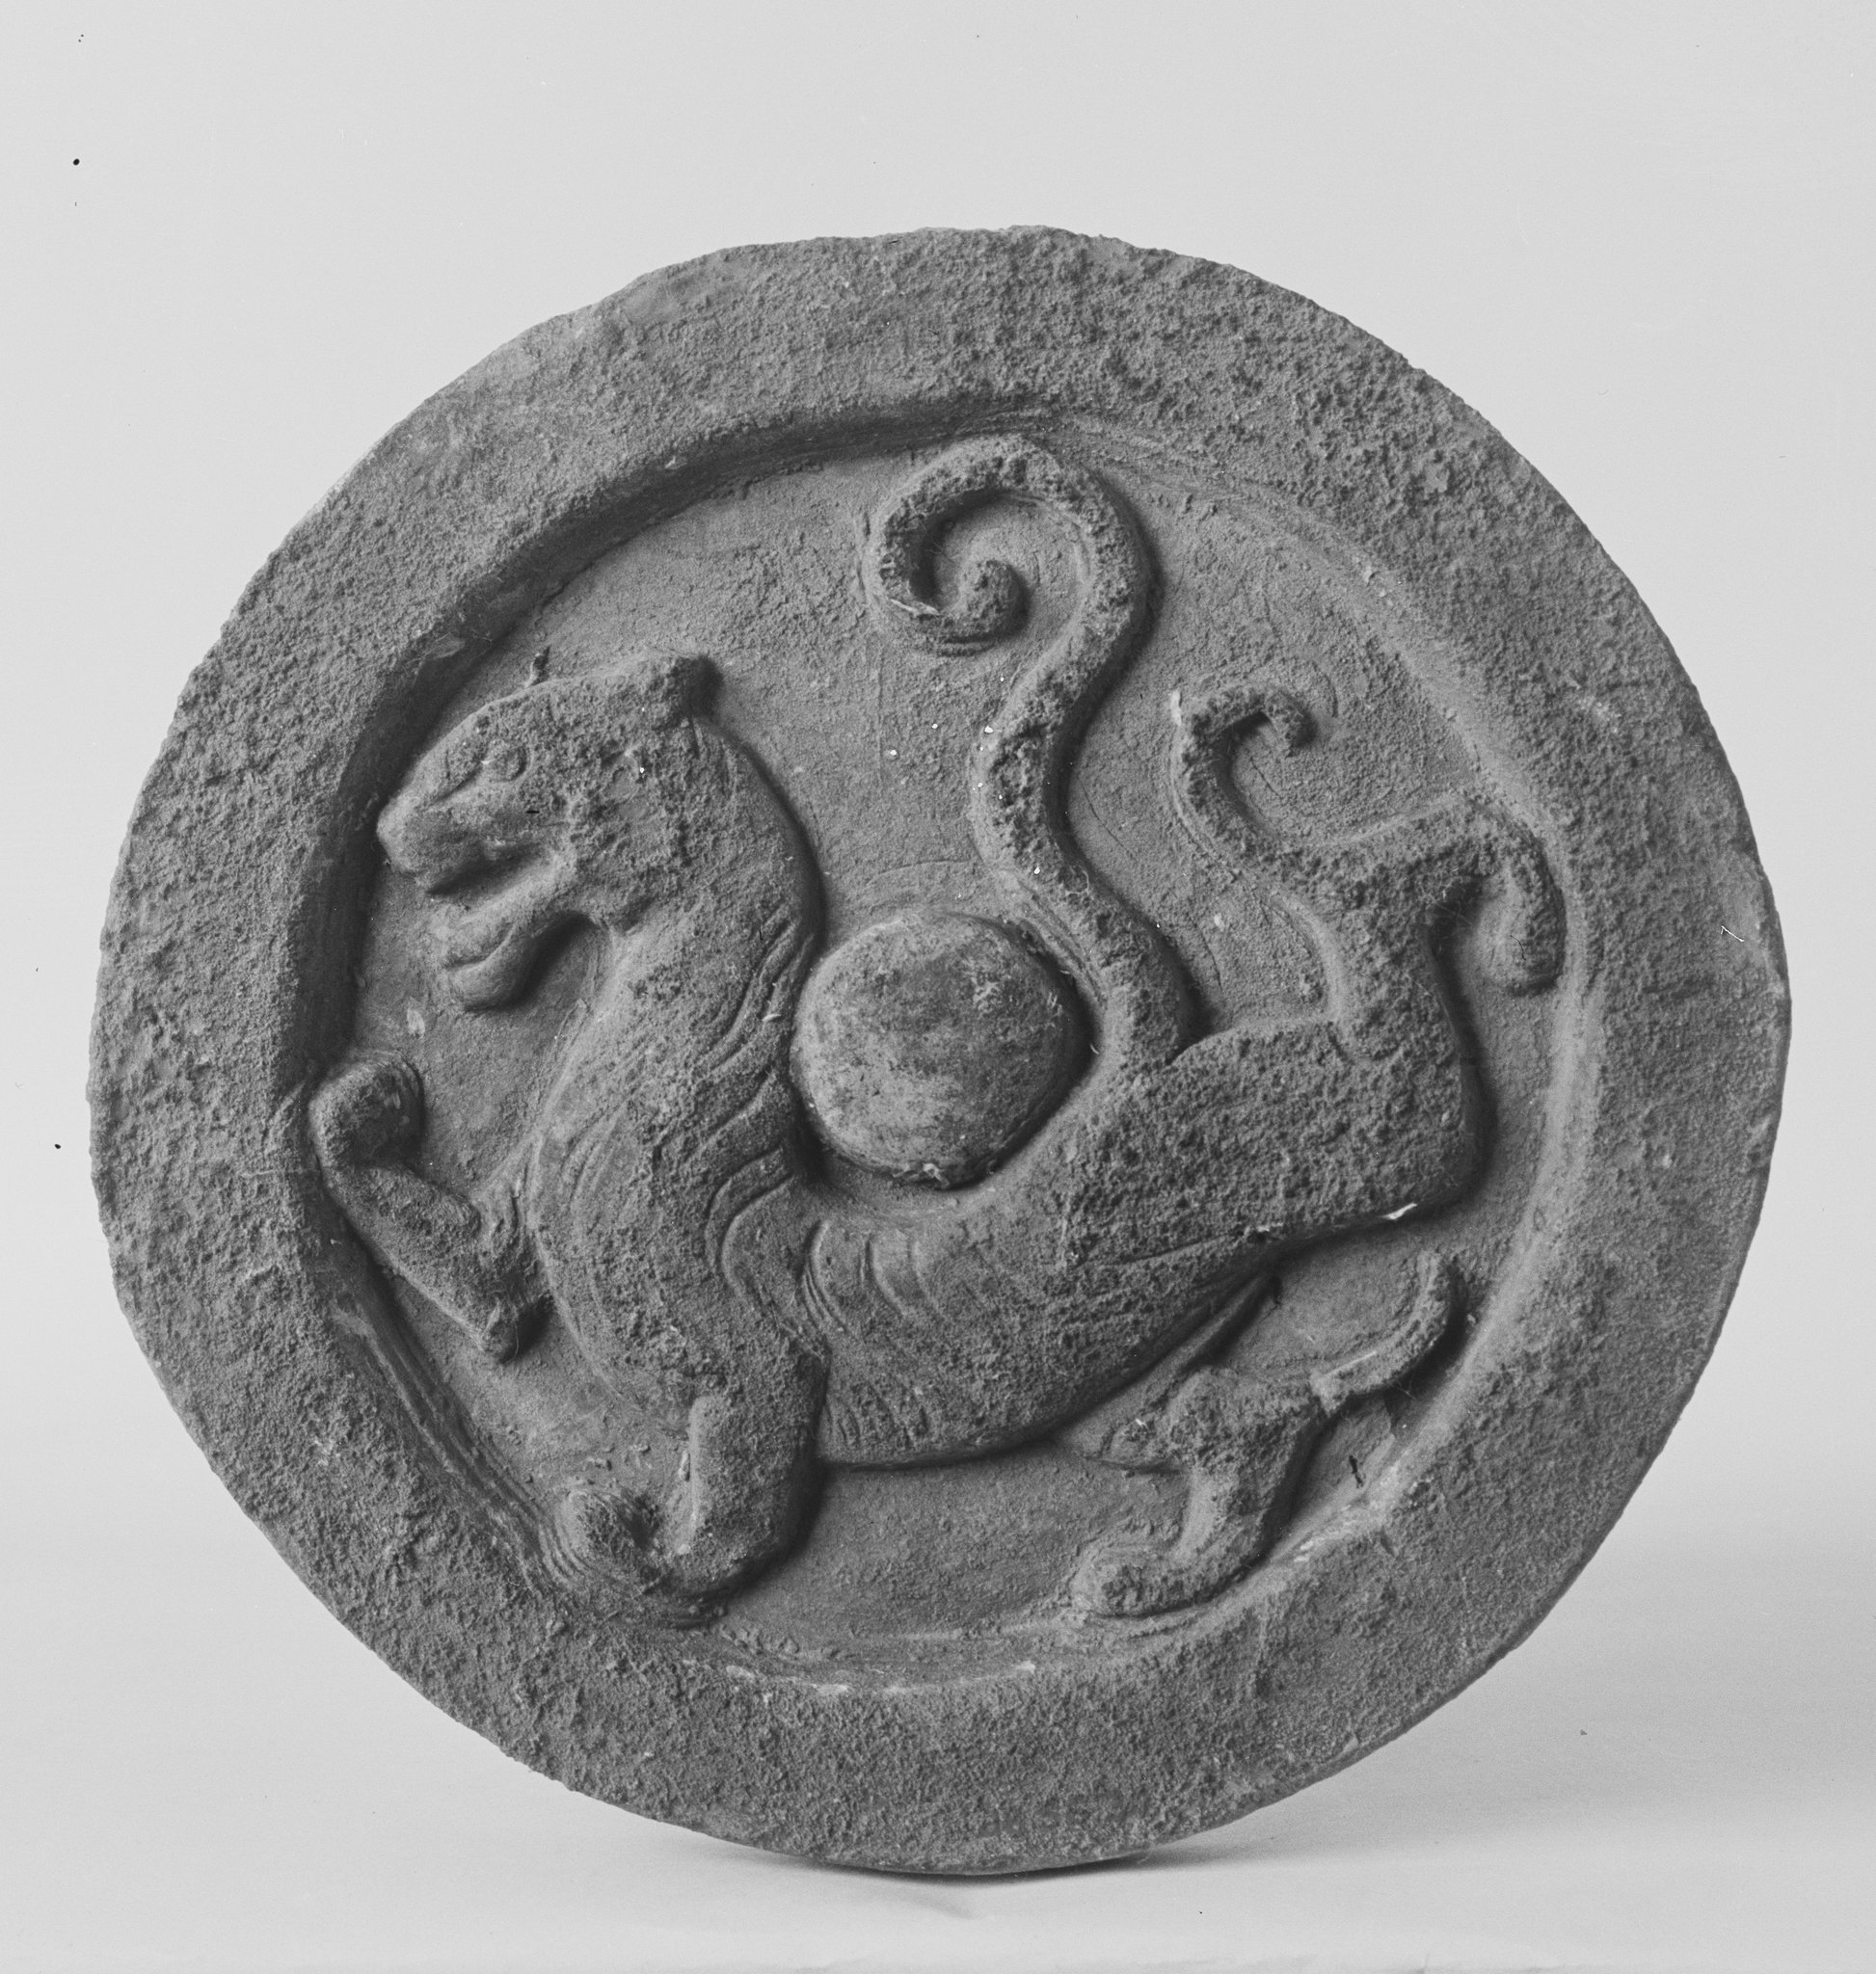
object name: roof tile end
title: Roof tile end with tiger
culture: chinese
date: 206 BCE-9 CE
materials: earthenware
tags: lions,tigers